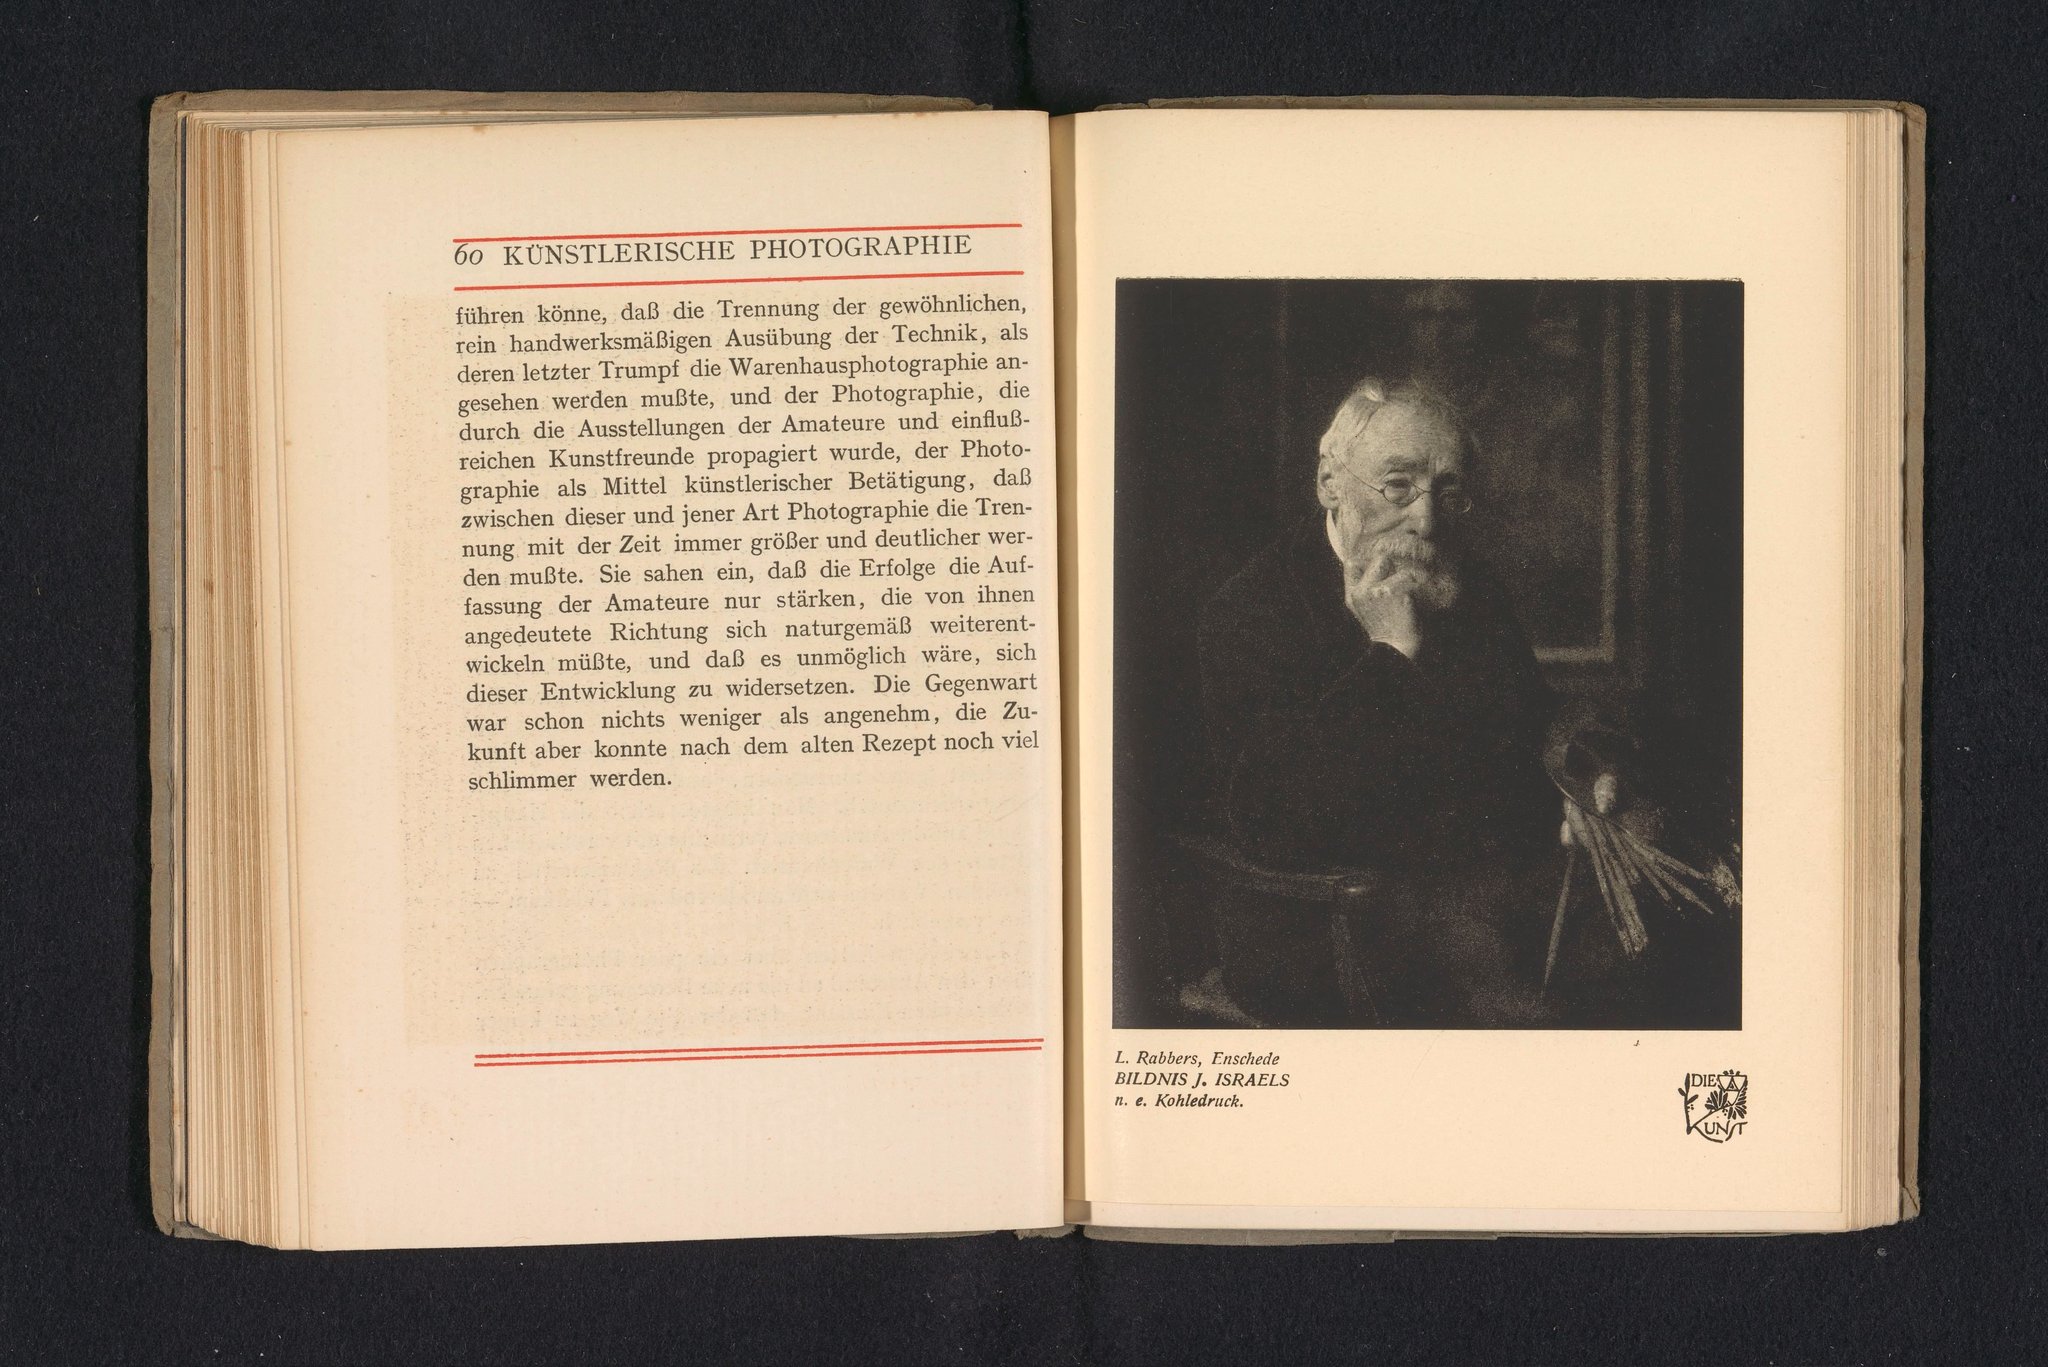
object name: photomechanical print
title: Fotoreproductie van een foto door L. Rabbers, voorstellend een portret van Jozef Israëls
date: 1880-1907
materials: paper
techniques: autotype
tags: the hague, painter, print maker, draughtsman, jozef israëls, portrait, self-portrait of painter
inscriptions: inscription: ‘n.e. Kohledruck.’